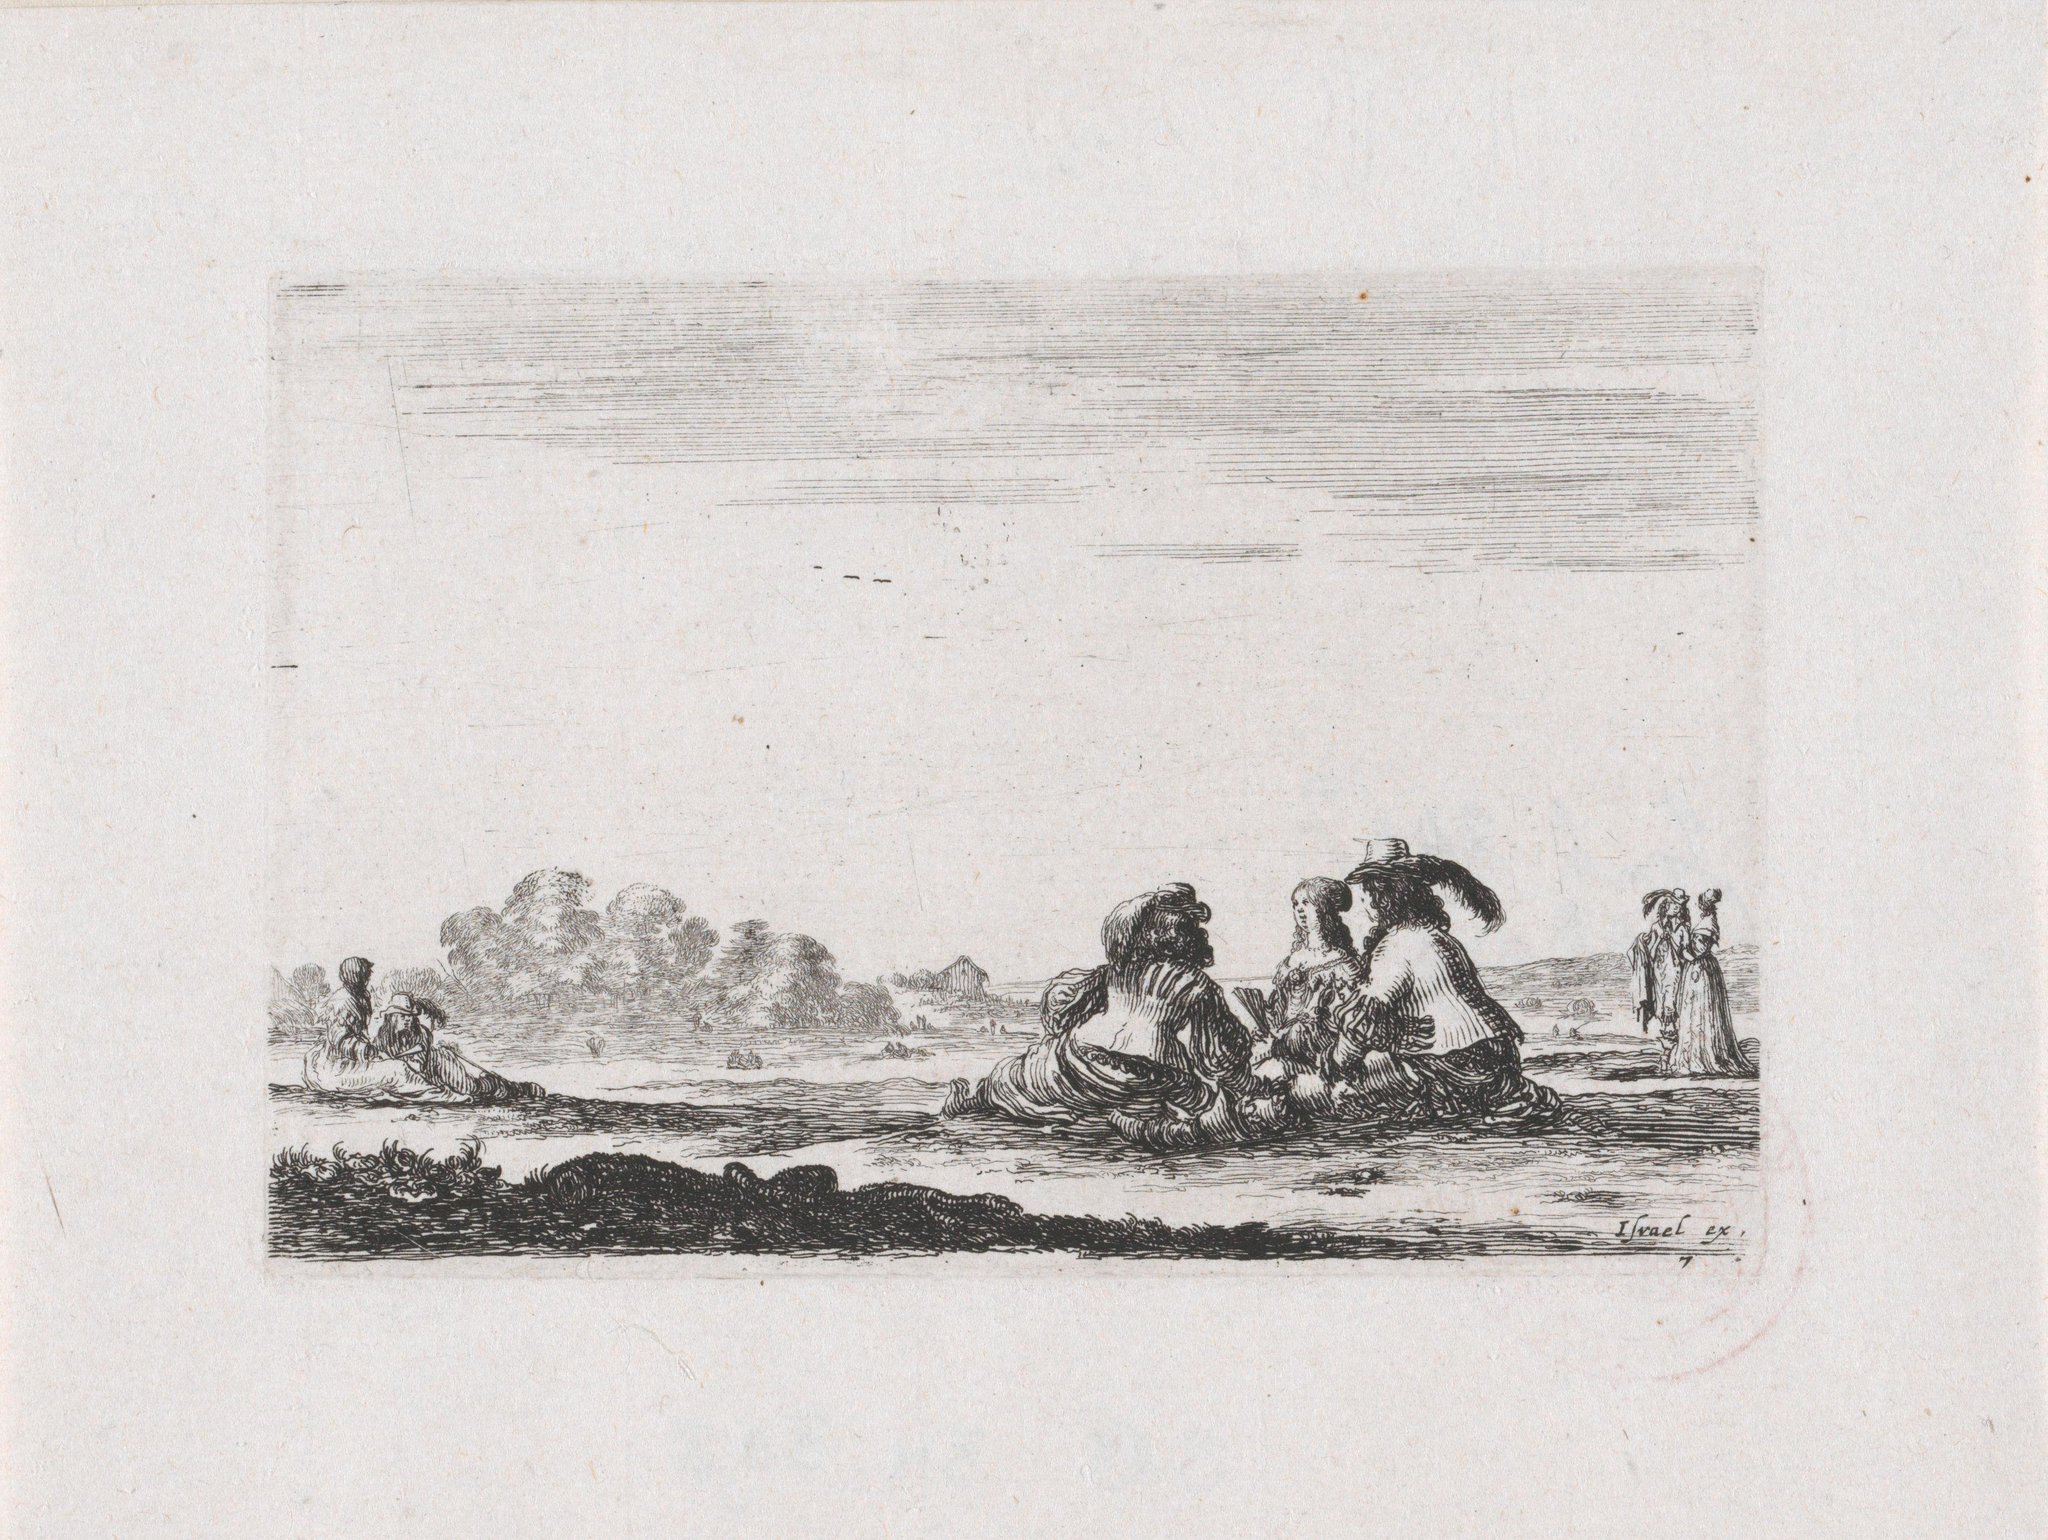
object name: print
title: Conversatie tussen twee mannen en een vrouw in een open veld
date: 1642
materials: paper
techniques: etching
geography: paris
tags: conversation, dialogue; conversation piece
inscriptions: collector's mark: Lugt 240